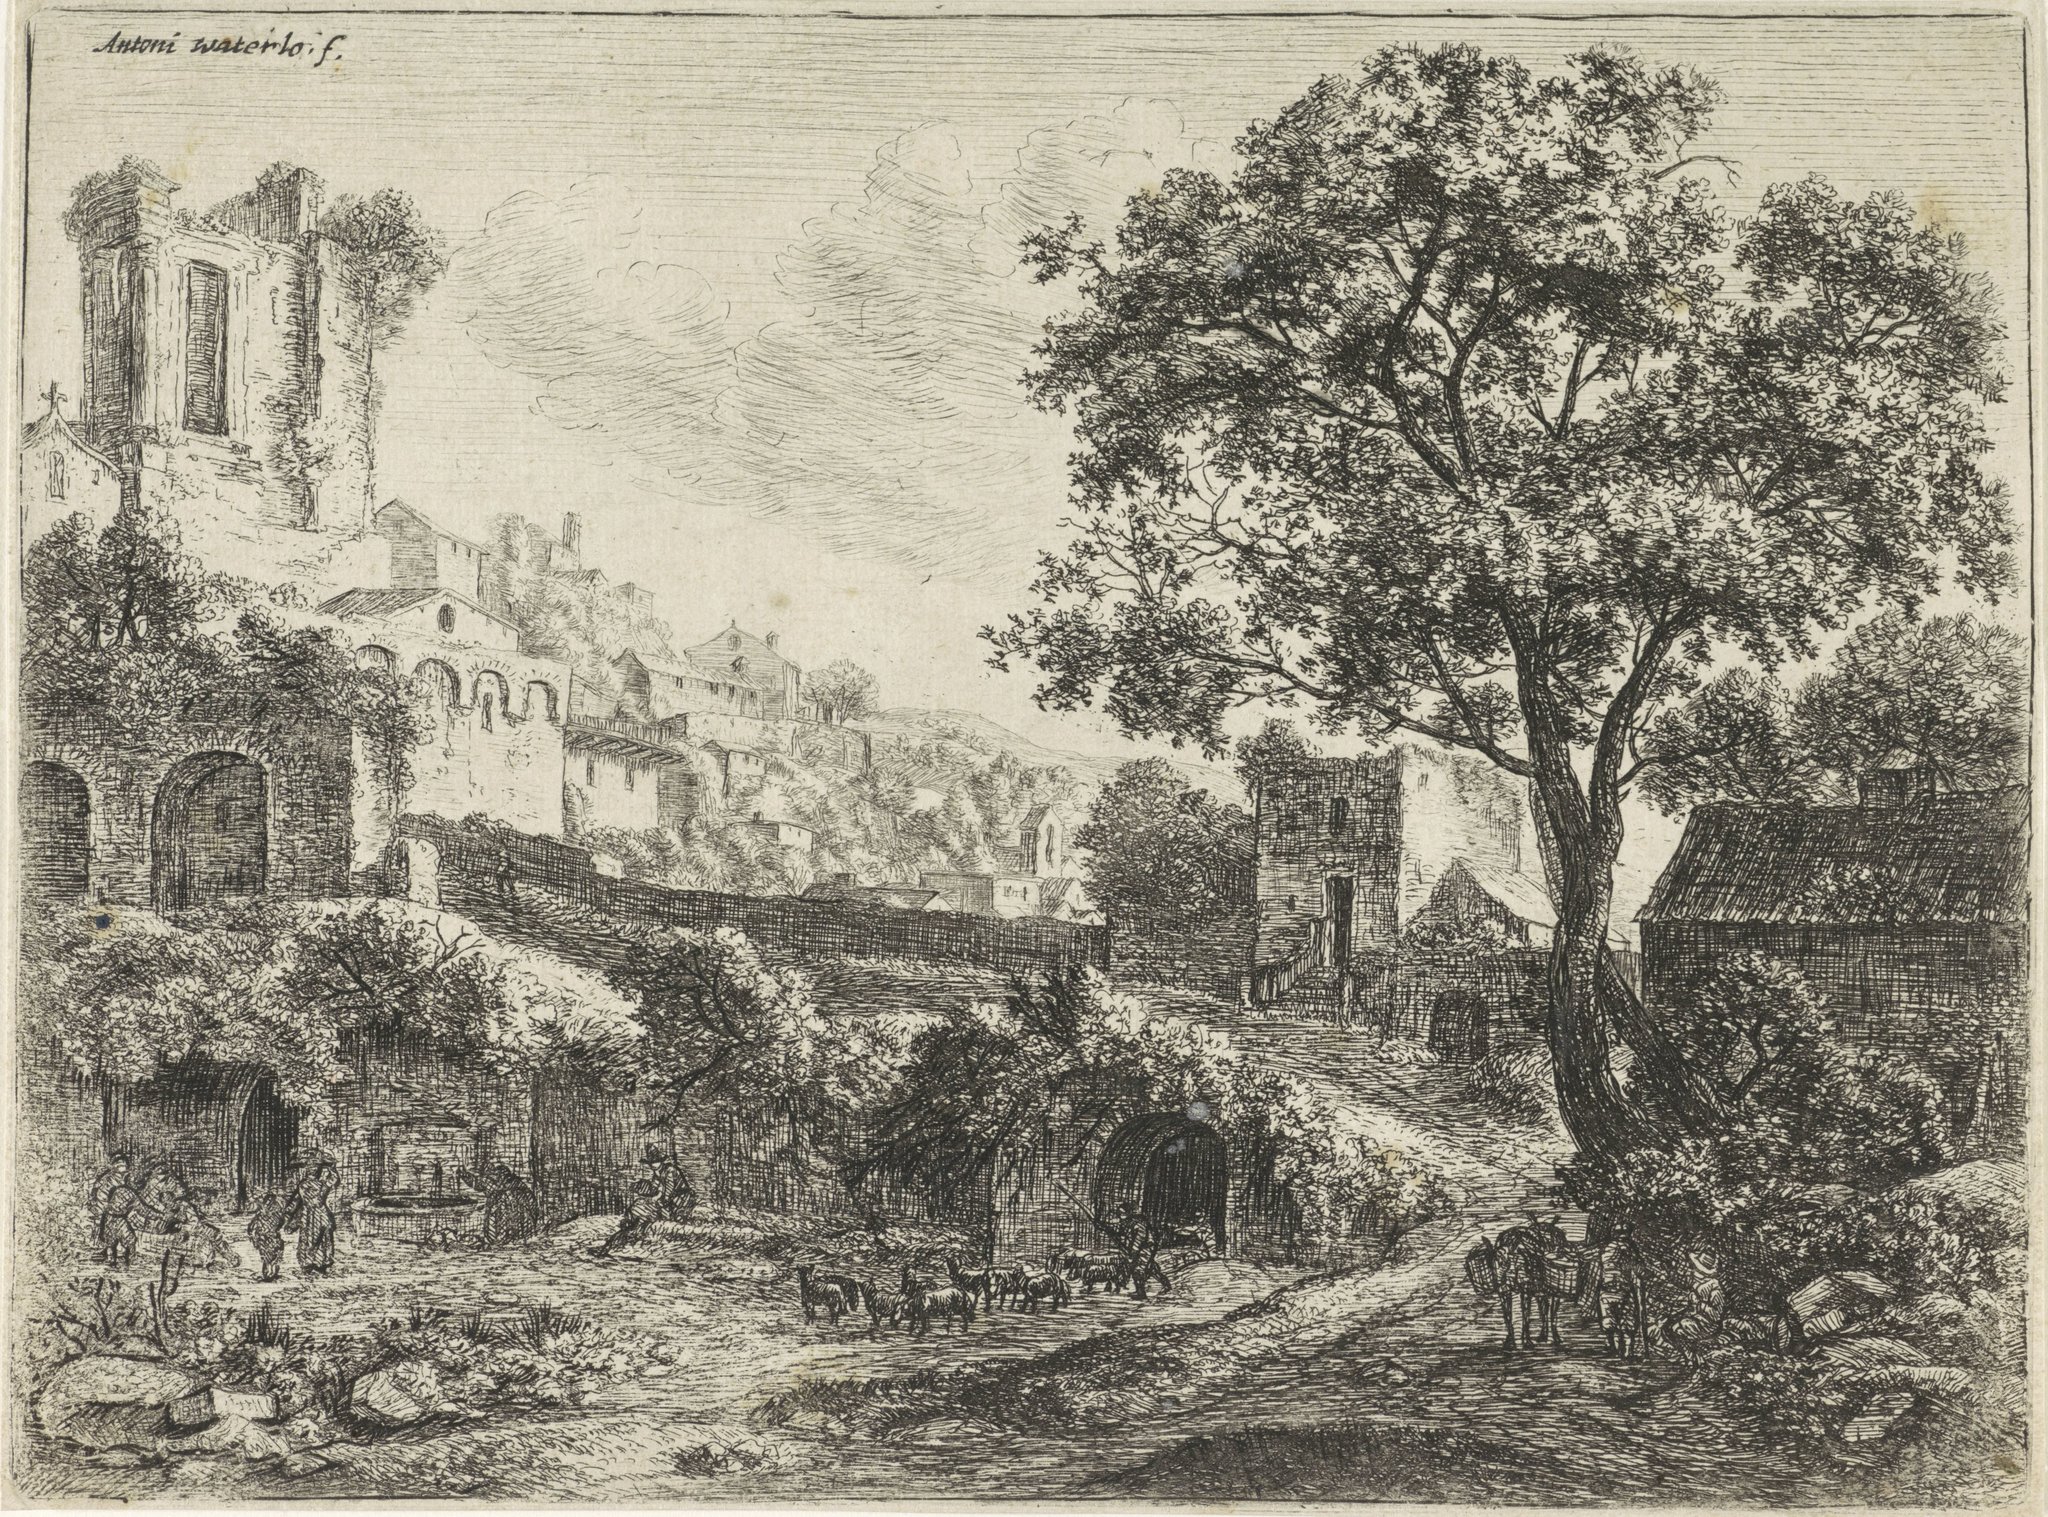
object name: print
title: Landschappen, serie A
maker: anthonie waterloo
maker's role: draughtsman, painter, print maker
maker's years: 1609-1690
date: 1630-1663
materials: paper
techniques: etching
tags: well, low hill country, herding, herdsman, herdswoman, shepherd, shepherdess, cowherd, etc., landscape with ruins, mule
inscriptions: collector's mark: Lugt 240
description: Aan de rand van een stad op een heuvel staat een ruïne van een gebouw. Voor de ruïne zijn enkele figuren bij een waterput op een open plek te zien. Rechts is een steil pad weergegeven met daarop een herder met zijn kudde en een muilezel.